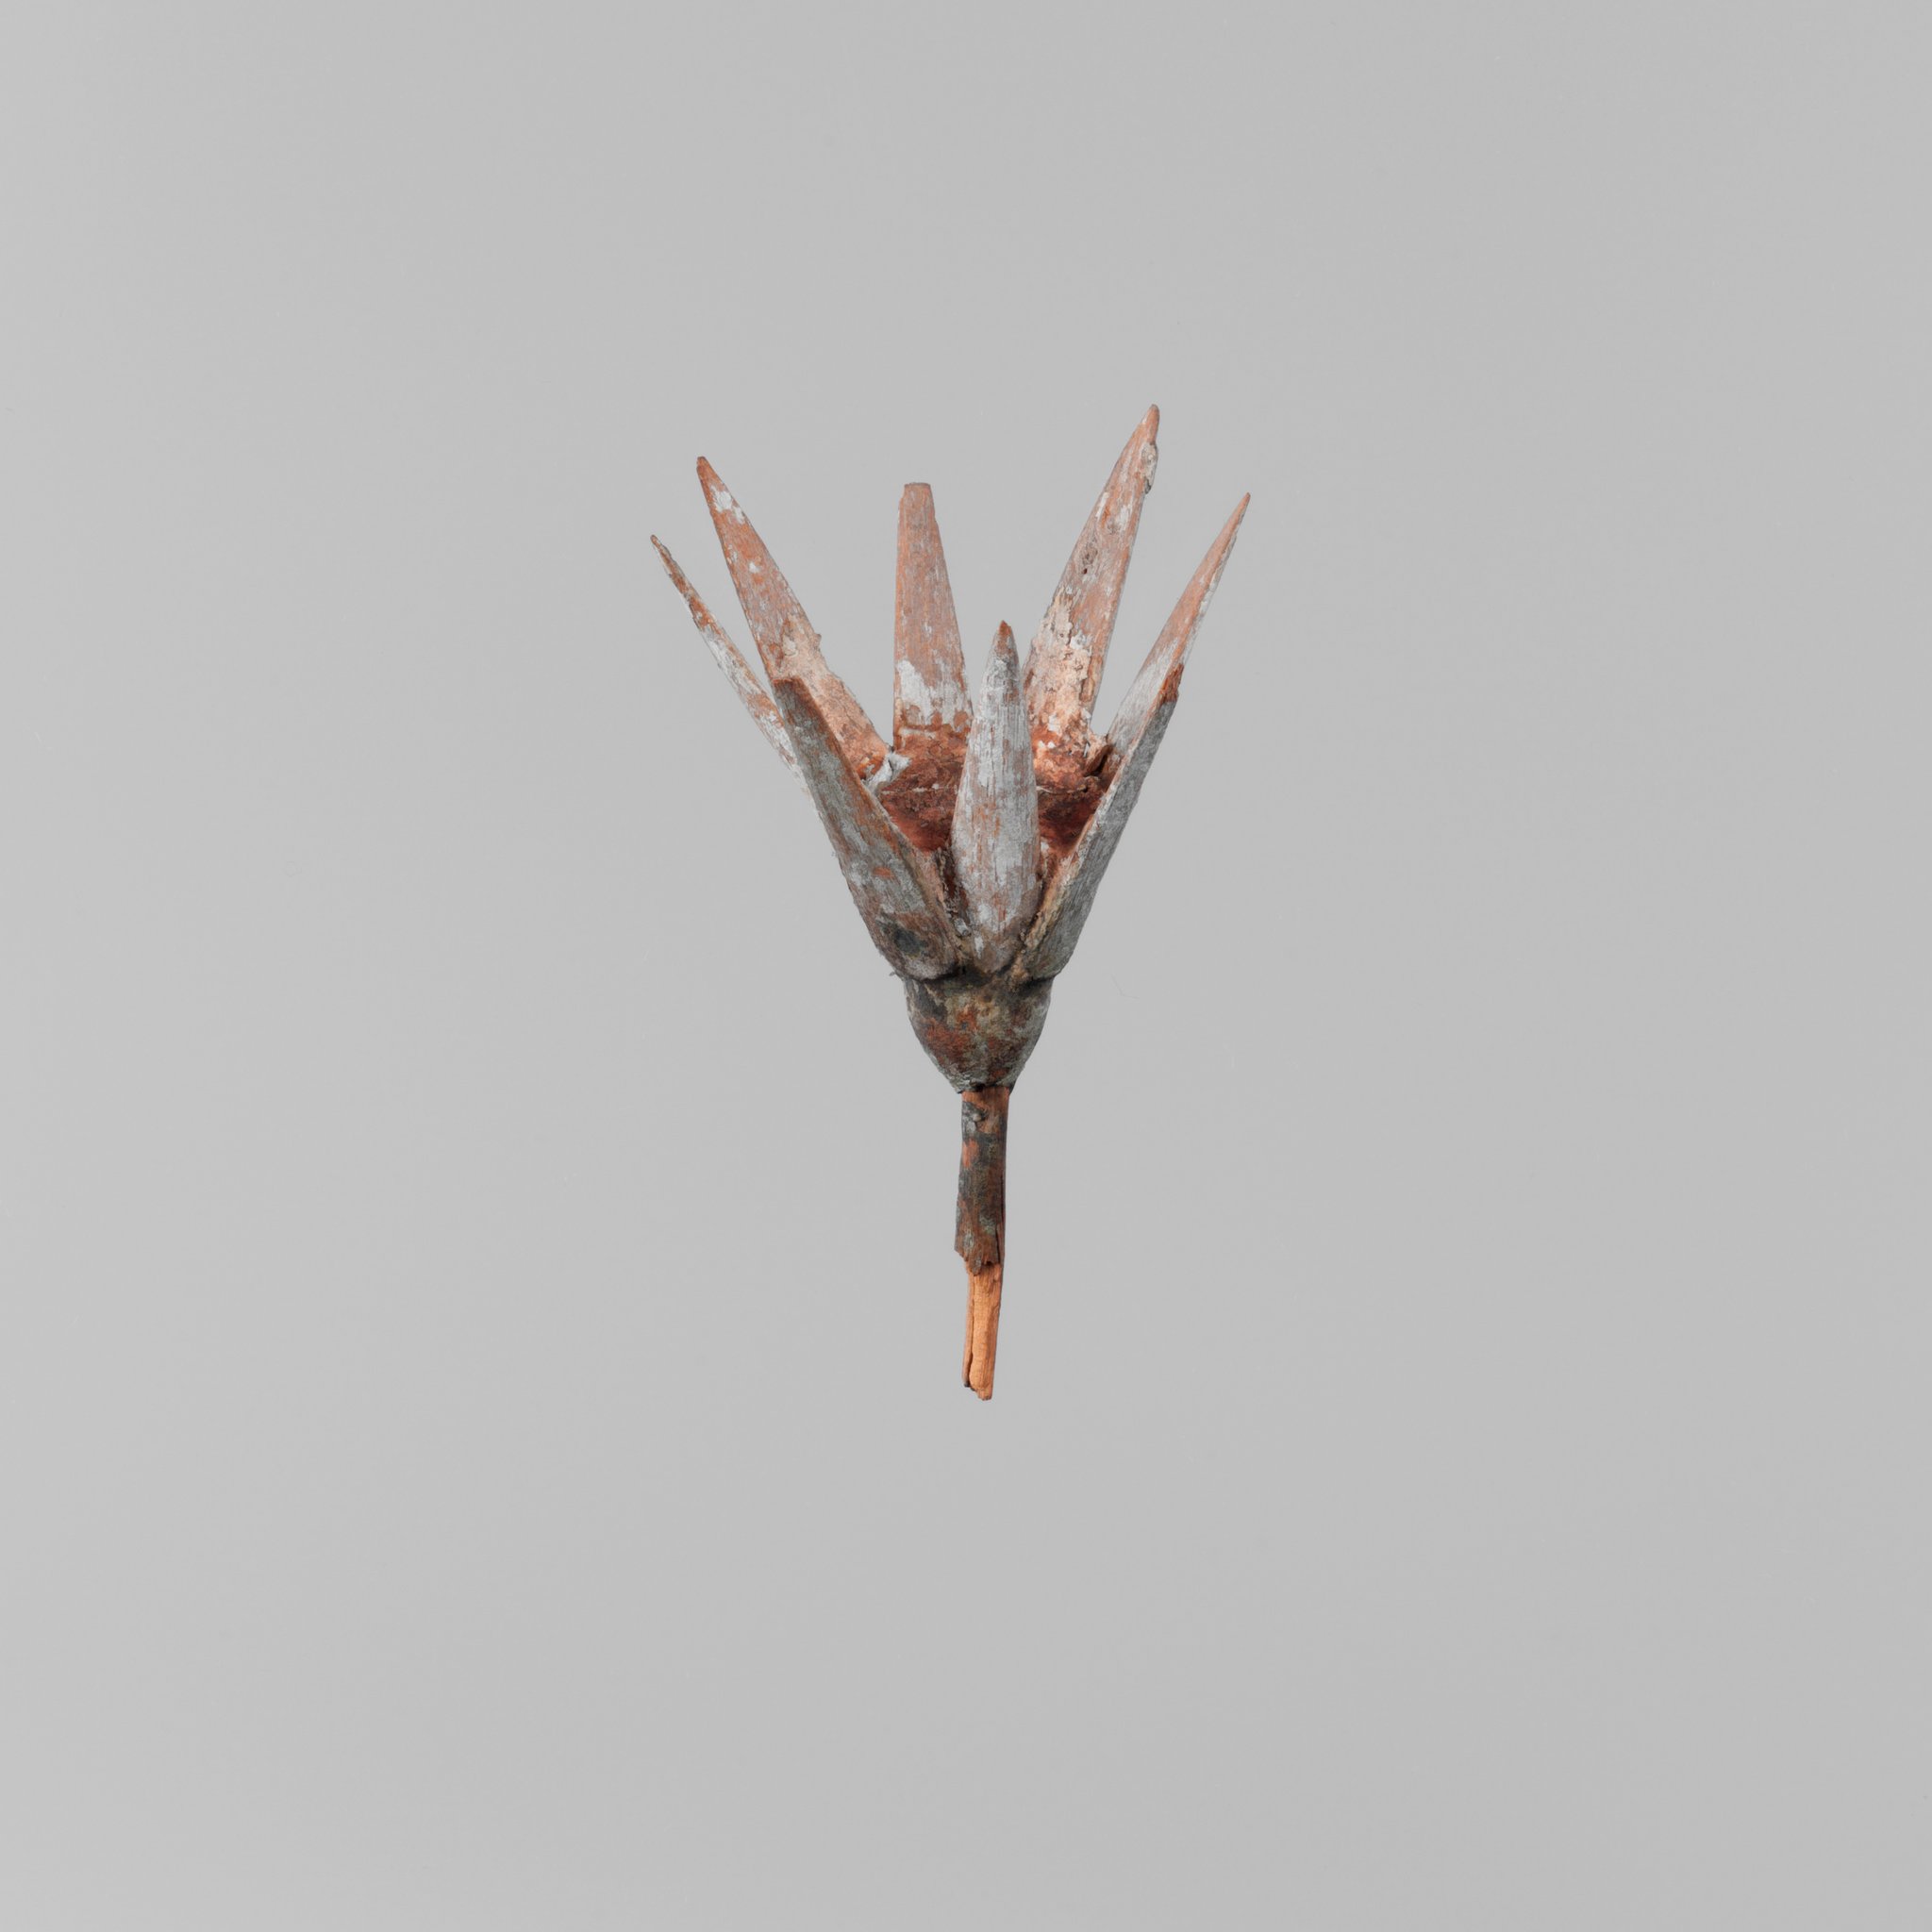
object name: model water lily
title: Model Lotus Flower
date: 2051-1981 BCE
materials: wood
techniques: painting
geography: egypt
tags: lotuses